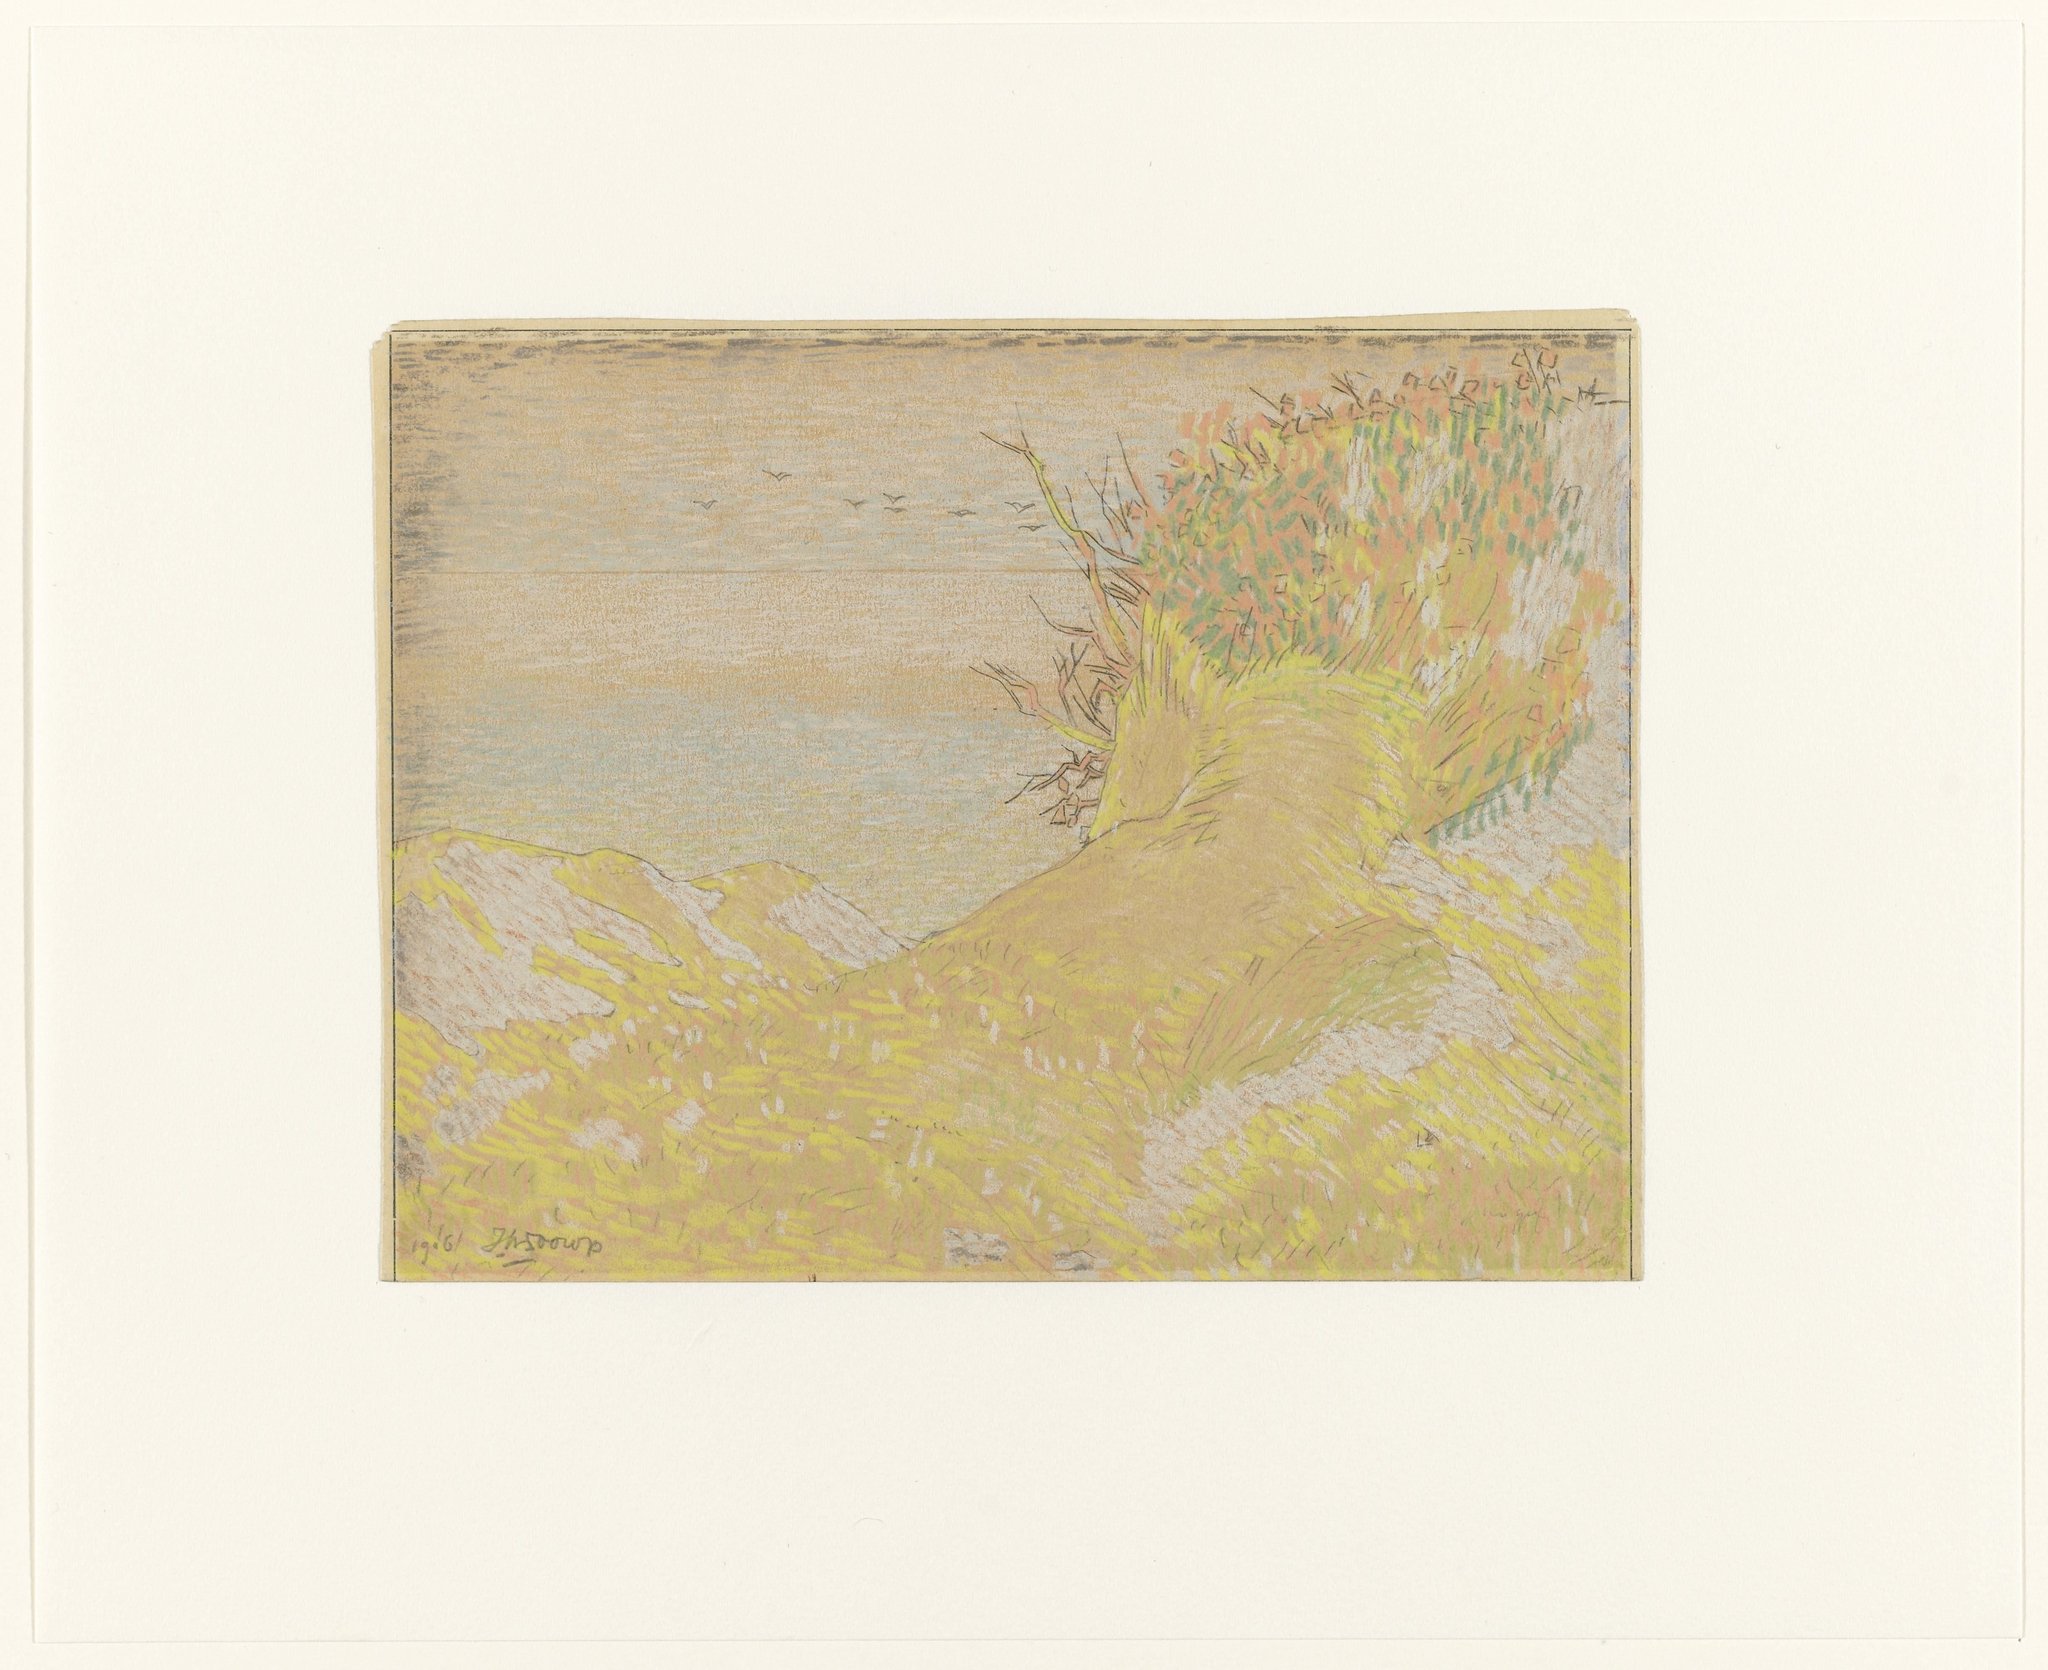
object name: drawing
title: Duinlandschap met gezicht op zee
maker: jan toorop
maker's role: draughtsman, painter, print maker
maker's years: 1858-1928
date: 1906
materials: chalk, paper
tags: dune coast